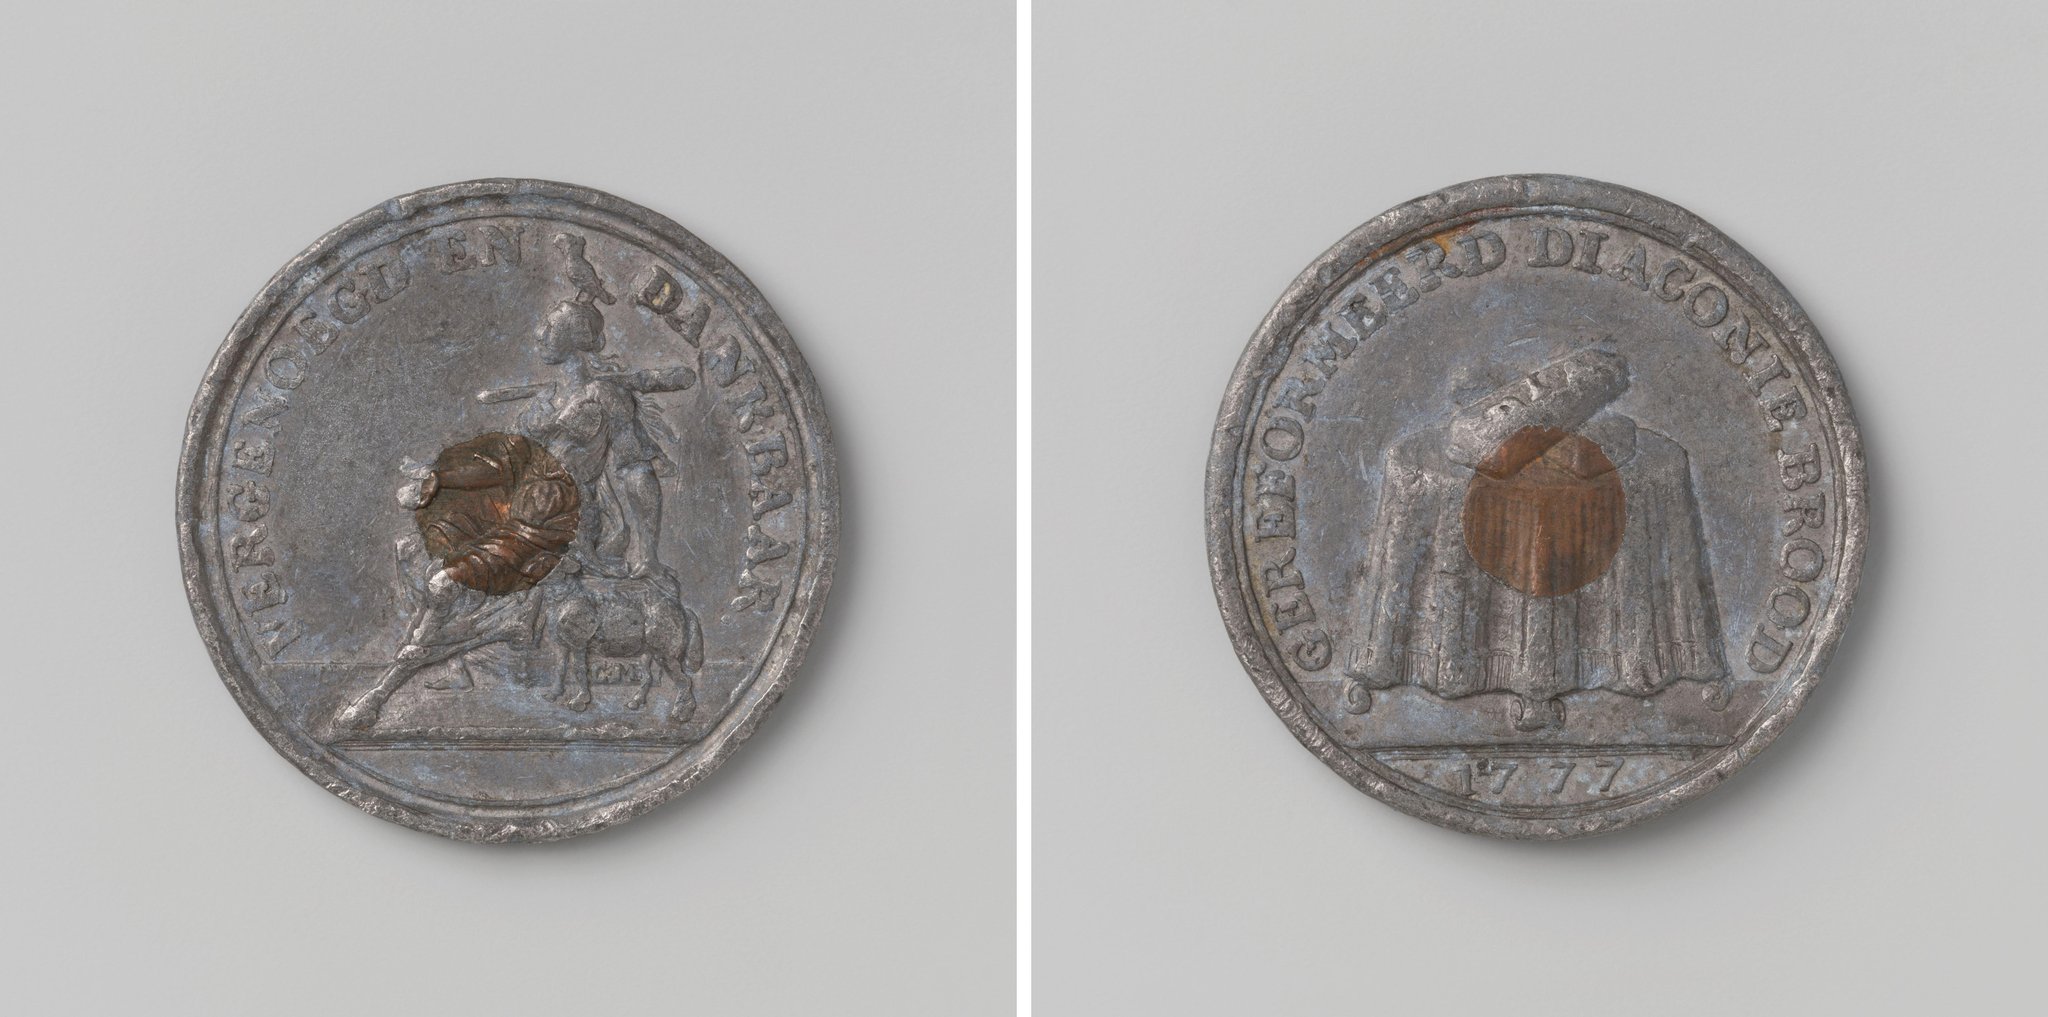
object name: alms token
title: Gereformeerde Diakonie te Amsterdam, armenpenning die behoeftige kerklidmaten bij uitdeling recht gaf op brood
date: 1777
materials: copper, lead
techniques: striking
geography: amsterdam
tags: amsterdam